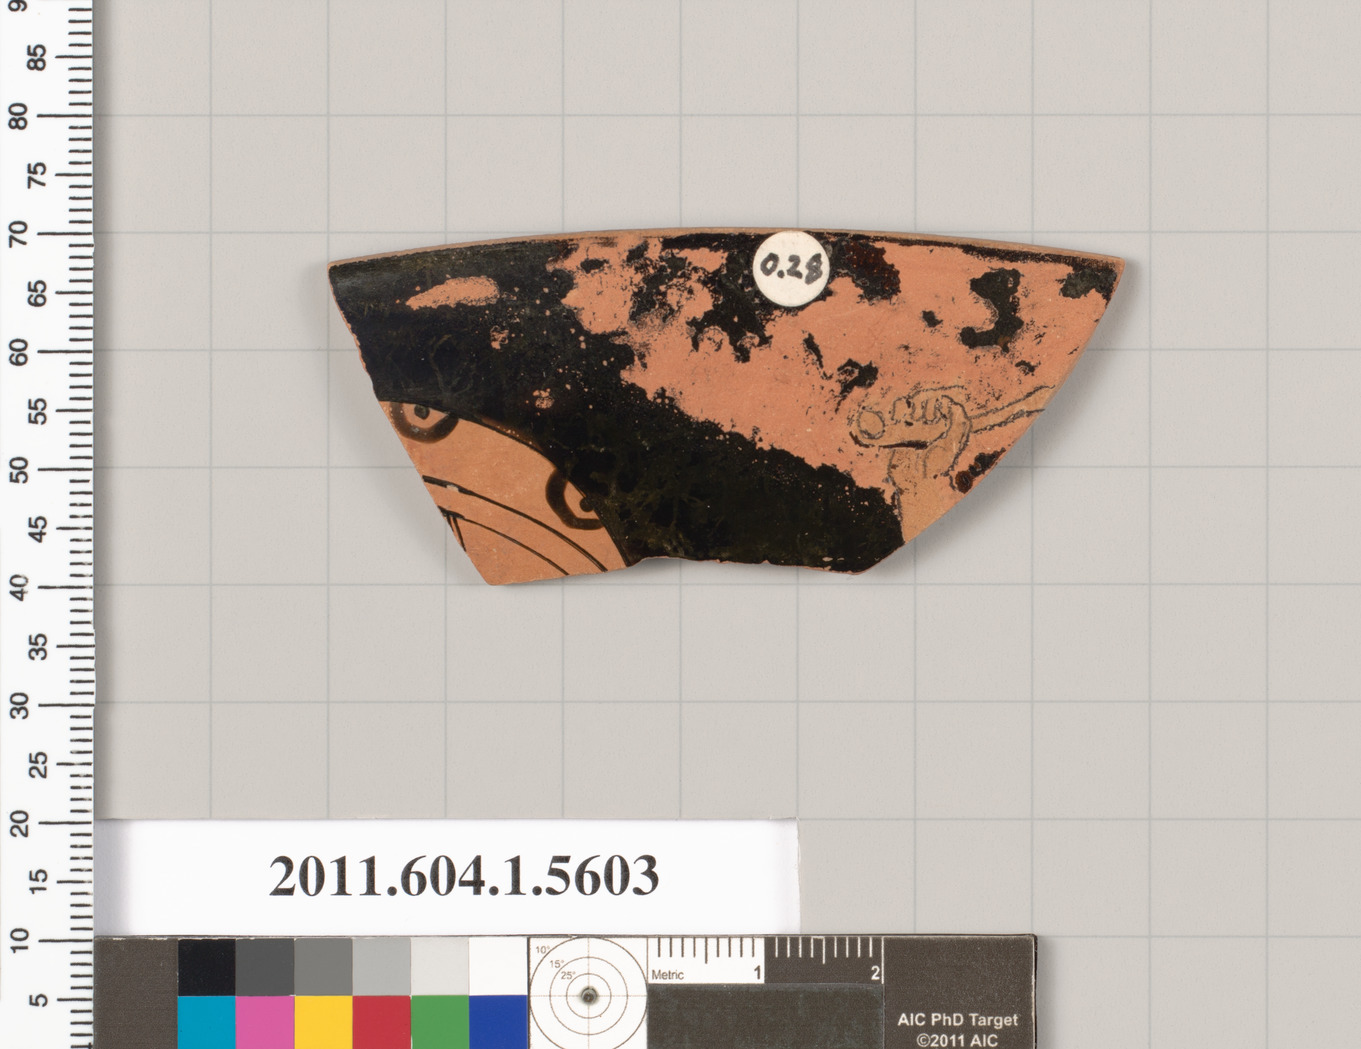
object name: kylix fragment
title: Terracotta rim fragment of a kylix (drinking cup)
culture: greek, attic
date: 510-490 BCE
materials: terracotta